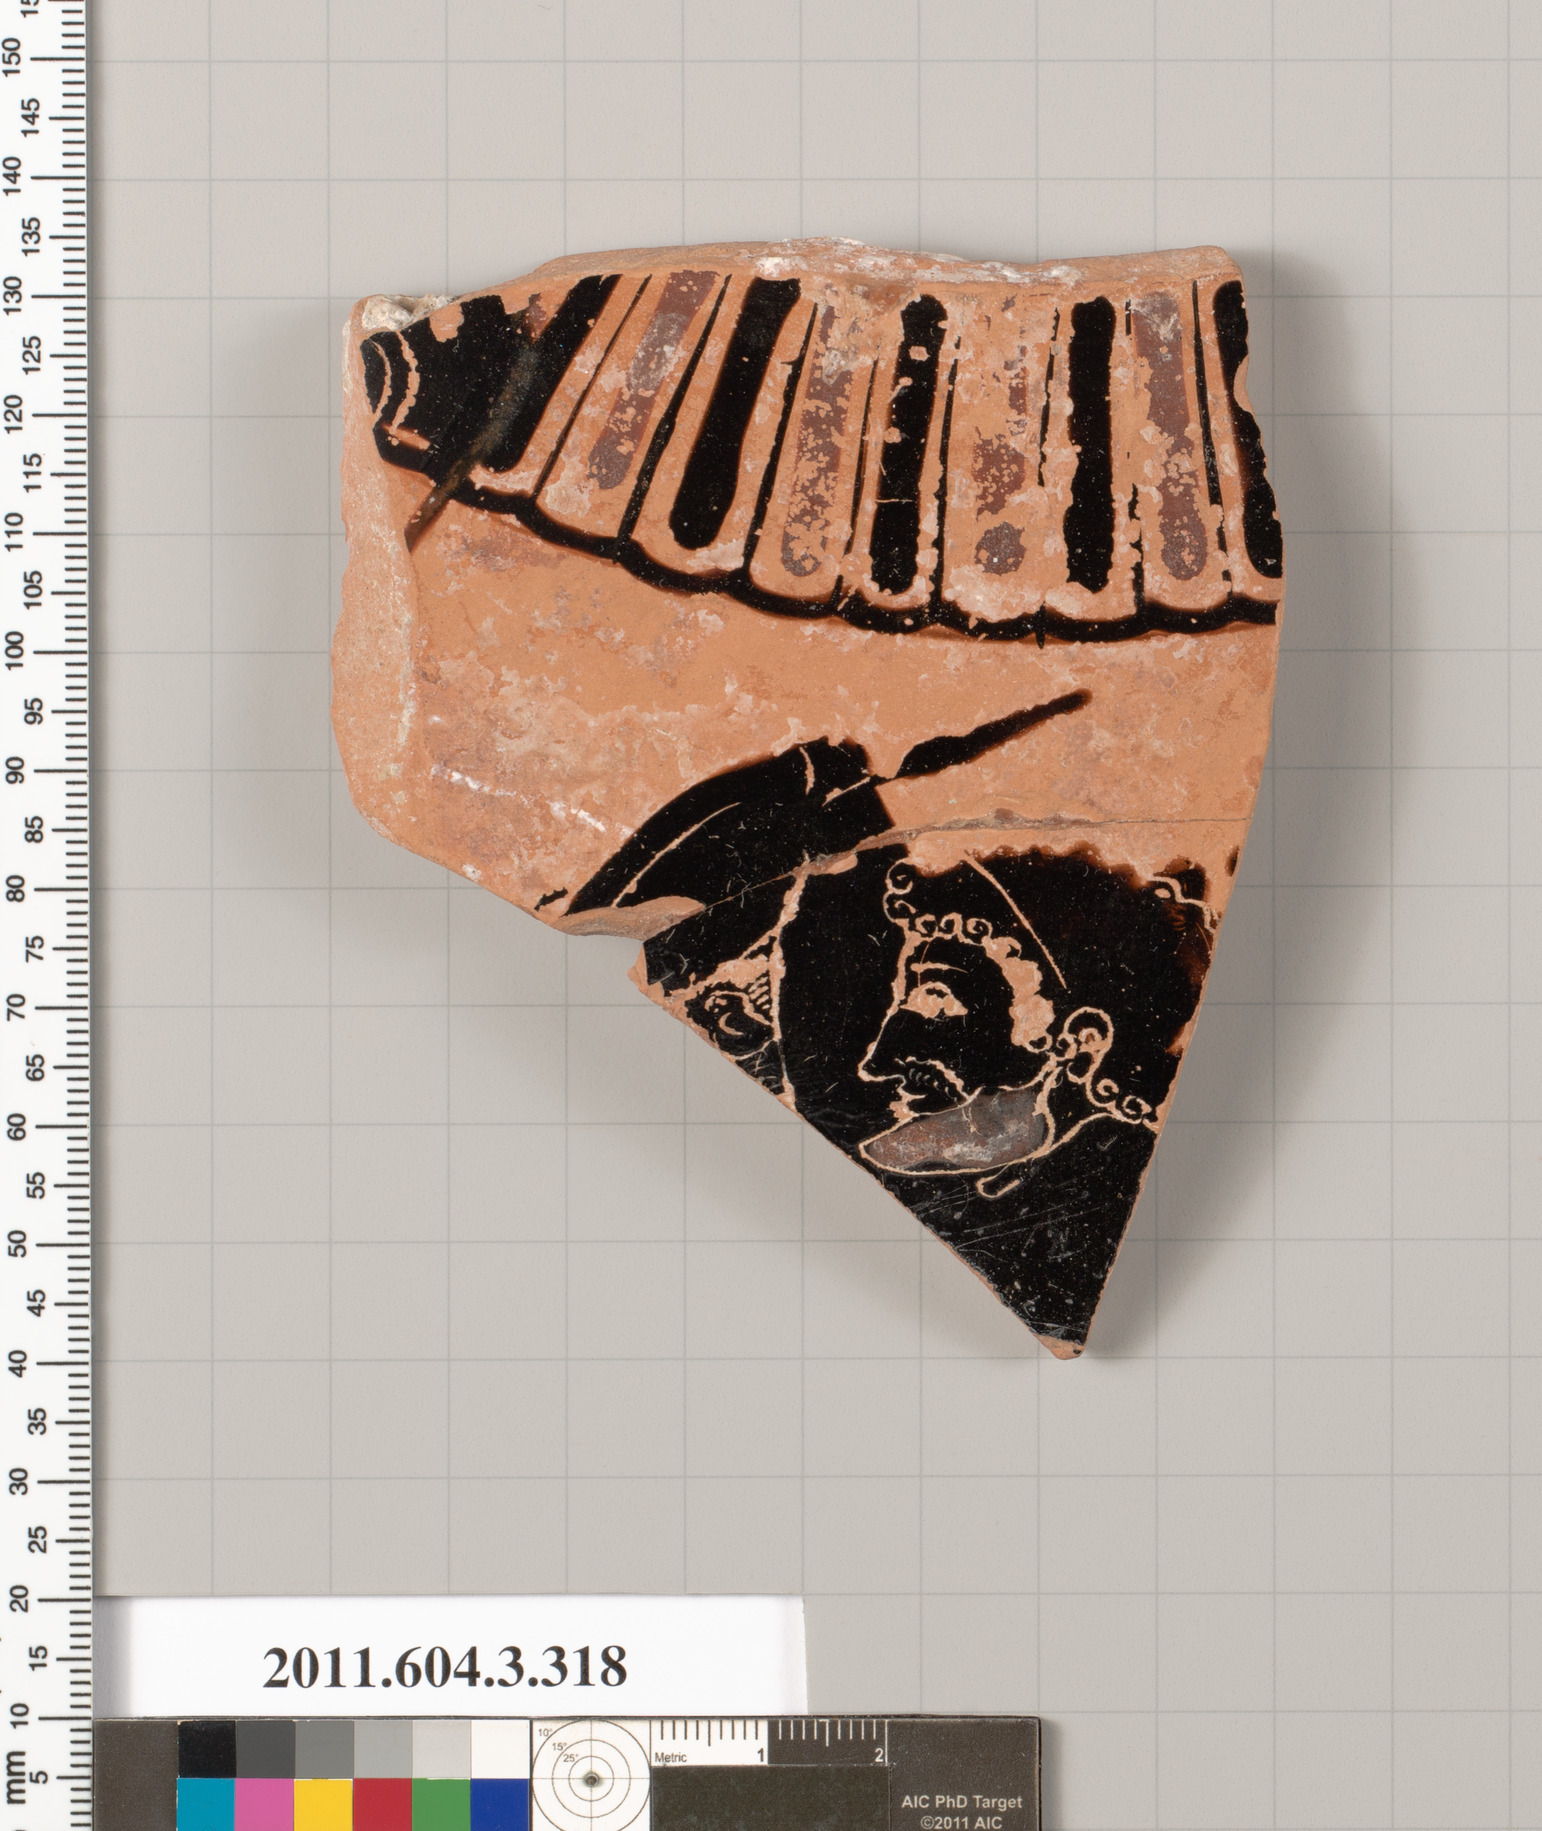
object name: neck amphora fragment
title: Terracotta fragment of a neck-amphora (jar)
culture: greek, attic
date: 525-501 BCE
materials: terracotta